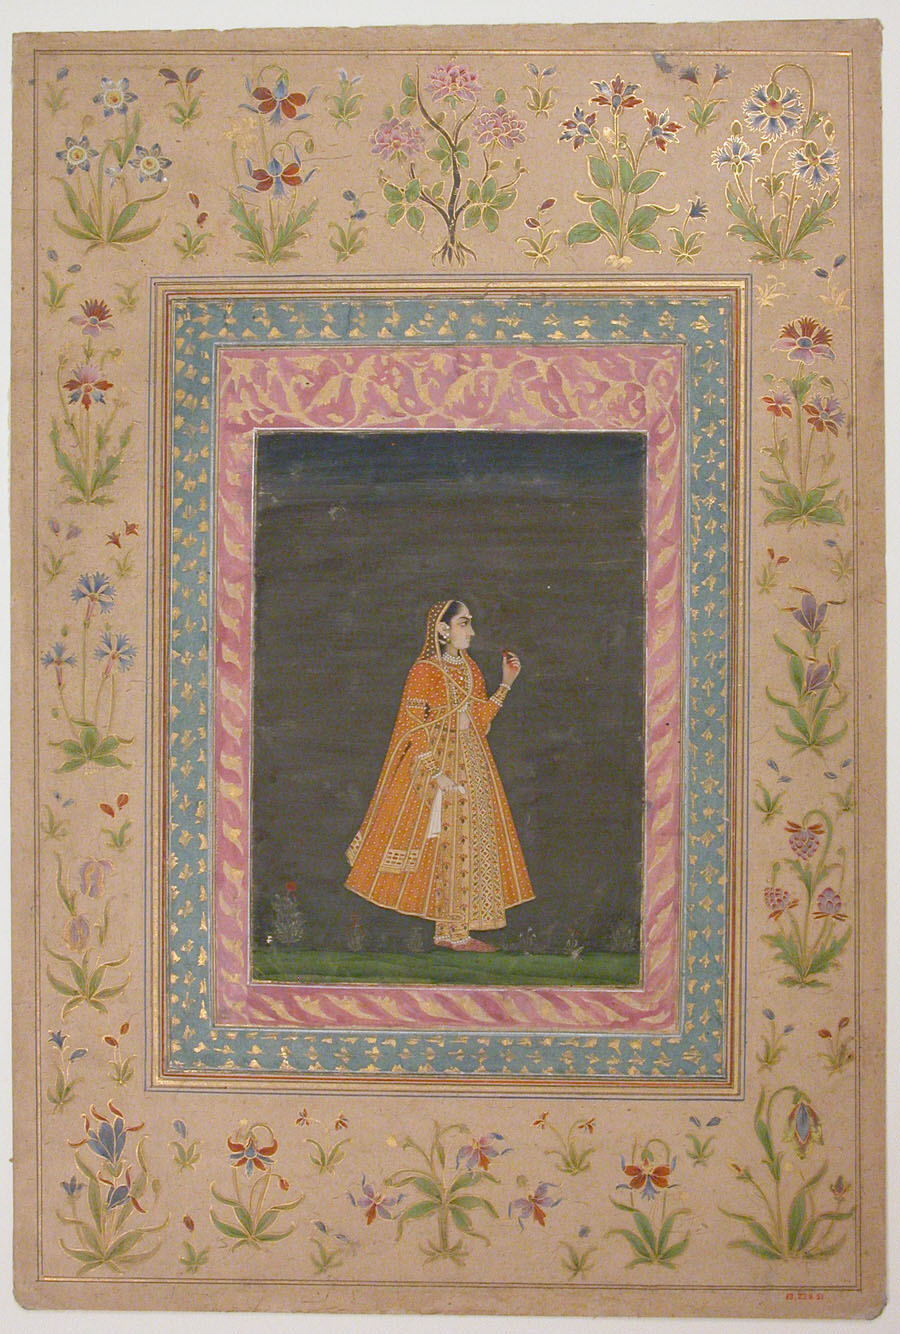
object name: illustrated album leaf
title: Portrait of a Woman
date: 1601-1700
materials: paper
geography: india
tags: profiles,women,flowers